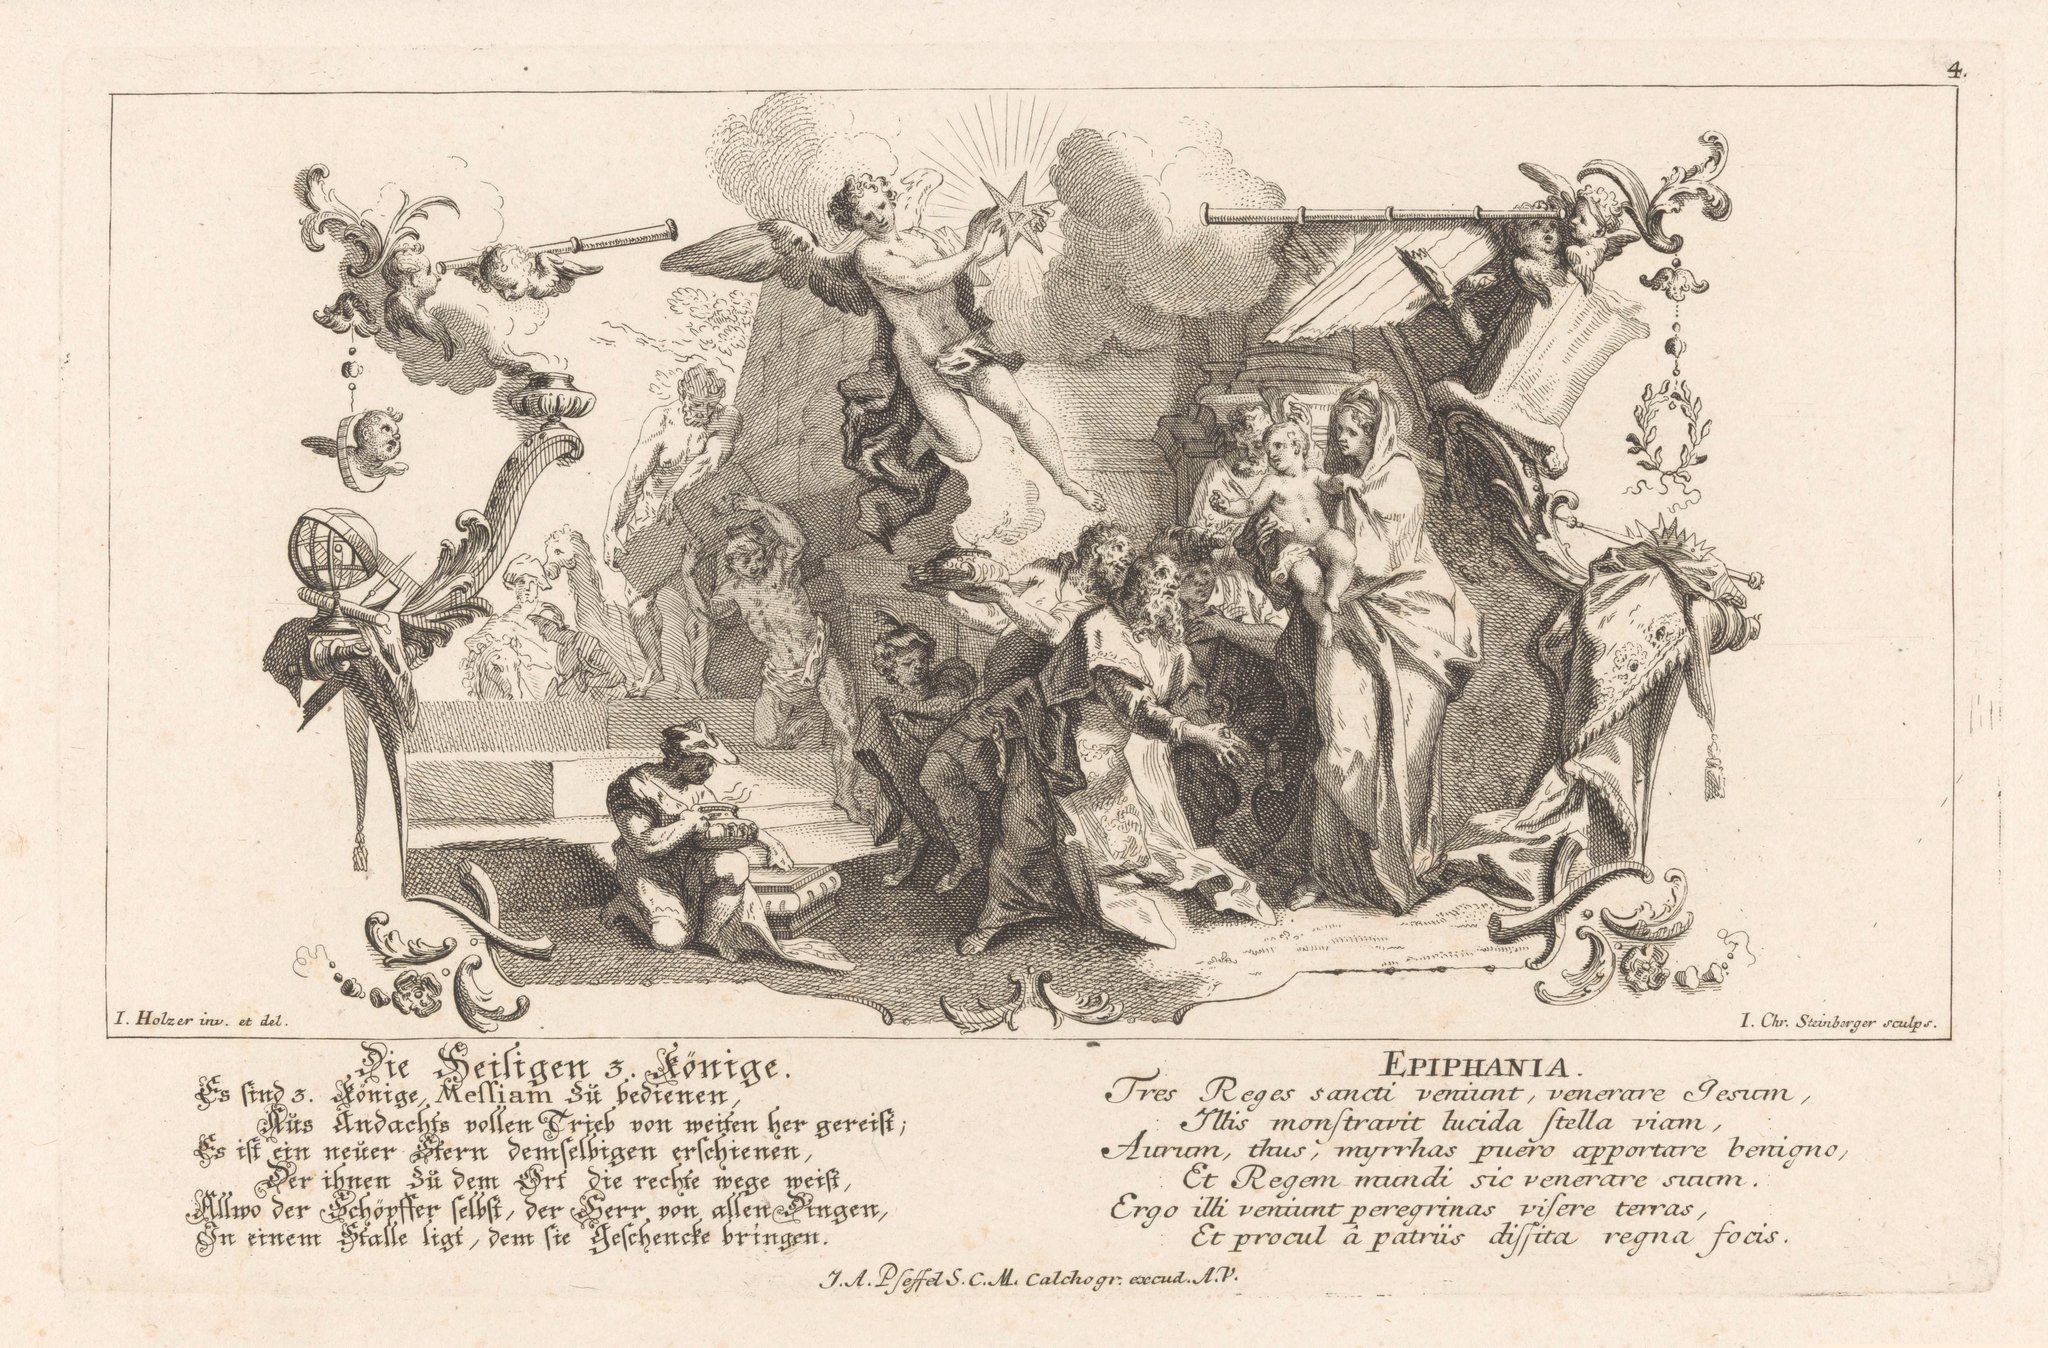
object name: ornament print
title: Jeugd van Christus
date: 1719-1727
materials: paper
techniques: etching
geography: augsburg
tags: adoration of the kings: the wise men present their gifts to the christ-child (gold, frankincense and myrrh)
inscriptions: collector's mark: Lugt 2760, collector's mark: Lugt 2228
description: De aanbidding van de drie koningen. Rechts staan Maria en Jozef met het Christuskind voor de drie knielende koningen. In het midden houdt een engel de ster vast die de wijzen de weg naar het kind wees. Links komt het gevolg van de koningen met geschenken. Rondom de voorstelling rocaille ornamenten. In de ondermarge tweemaal een zevenregelige Duitse en Latijnse tekst.